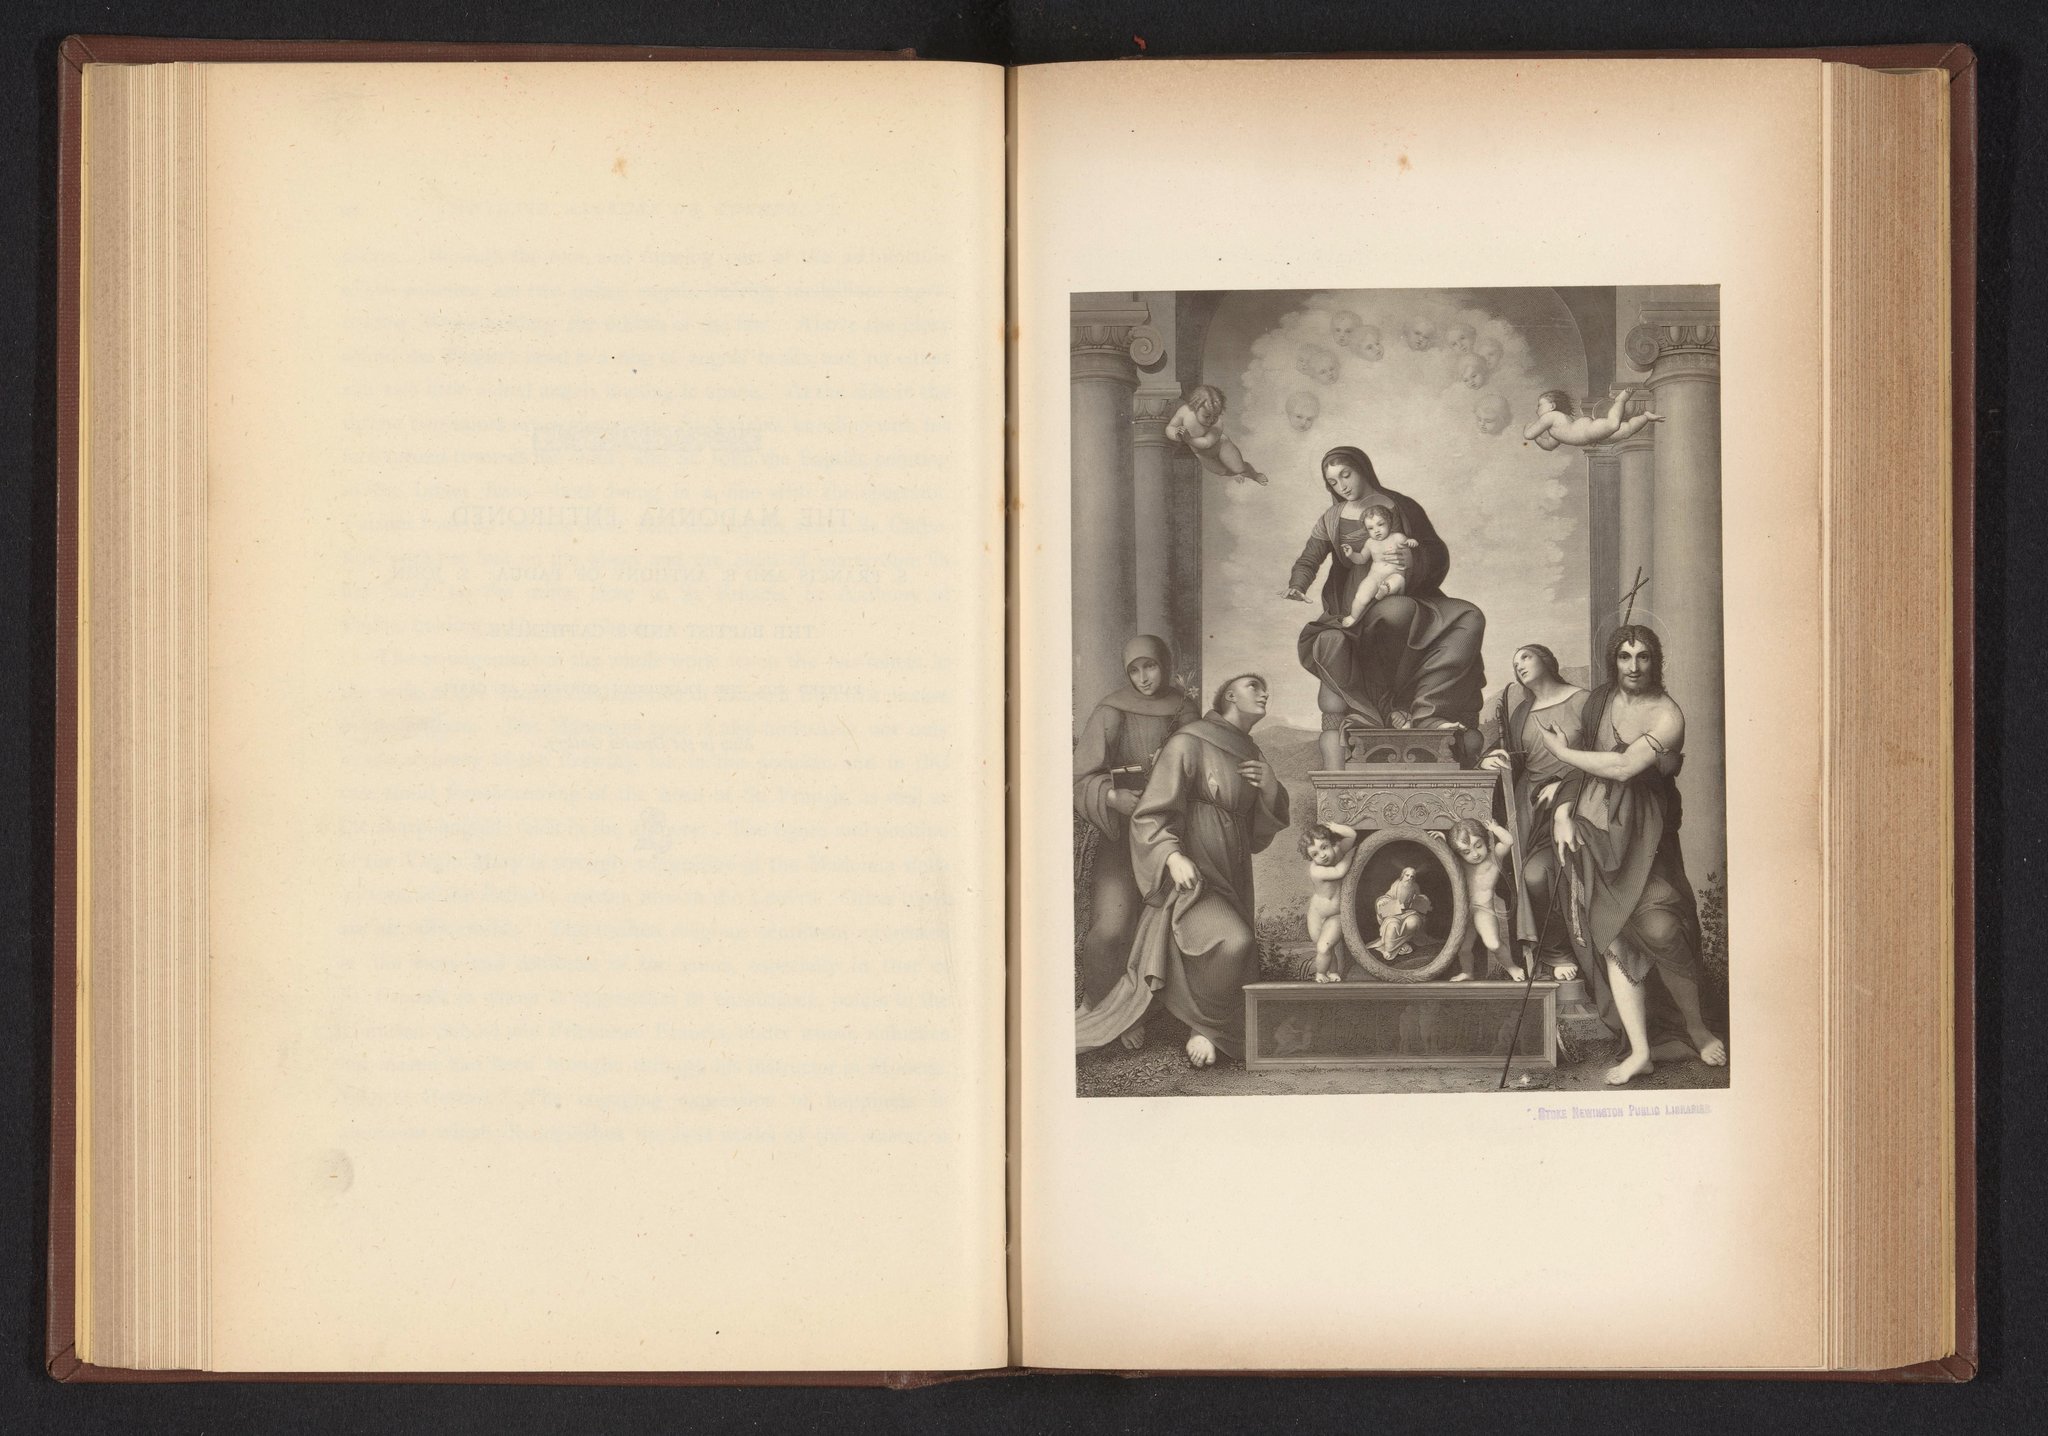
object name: page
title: Fotoreproductie van een prent naar een schilderij, voorstellende de tronende Madonna tussen heiligen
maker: Anonymous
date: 1870-1876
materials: paper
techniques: woodburytype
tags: madonna: mary sitting or enthroned, the christ-child in her lap (or in front of her bosom) (mary sometimes represented half-length), saints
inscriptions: inscription: ‘Stoke Newington Public Libraries’